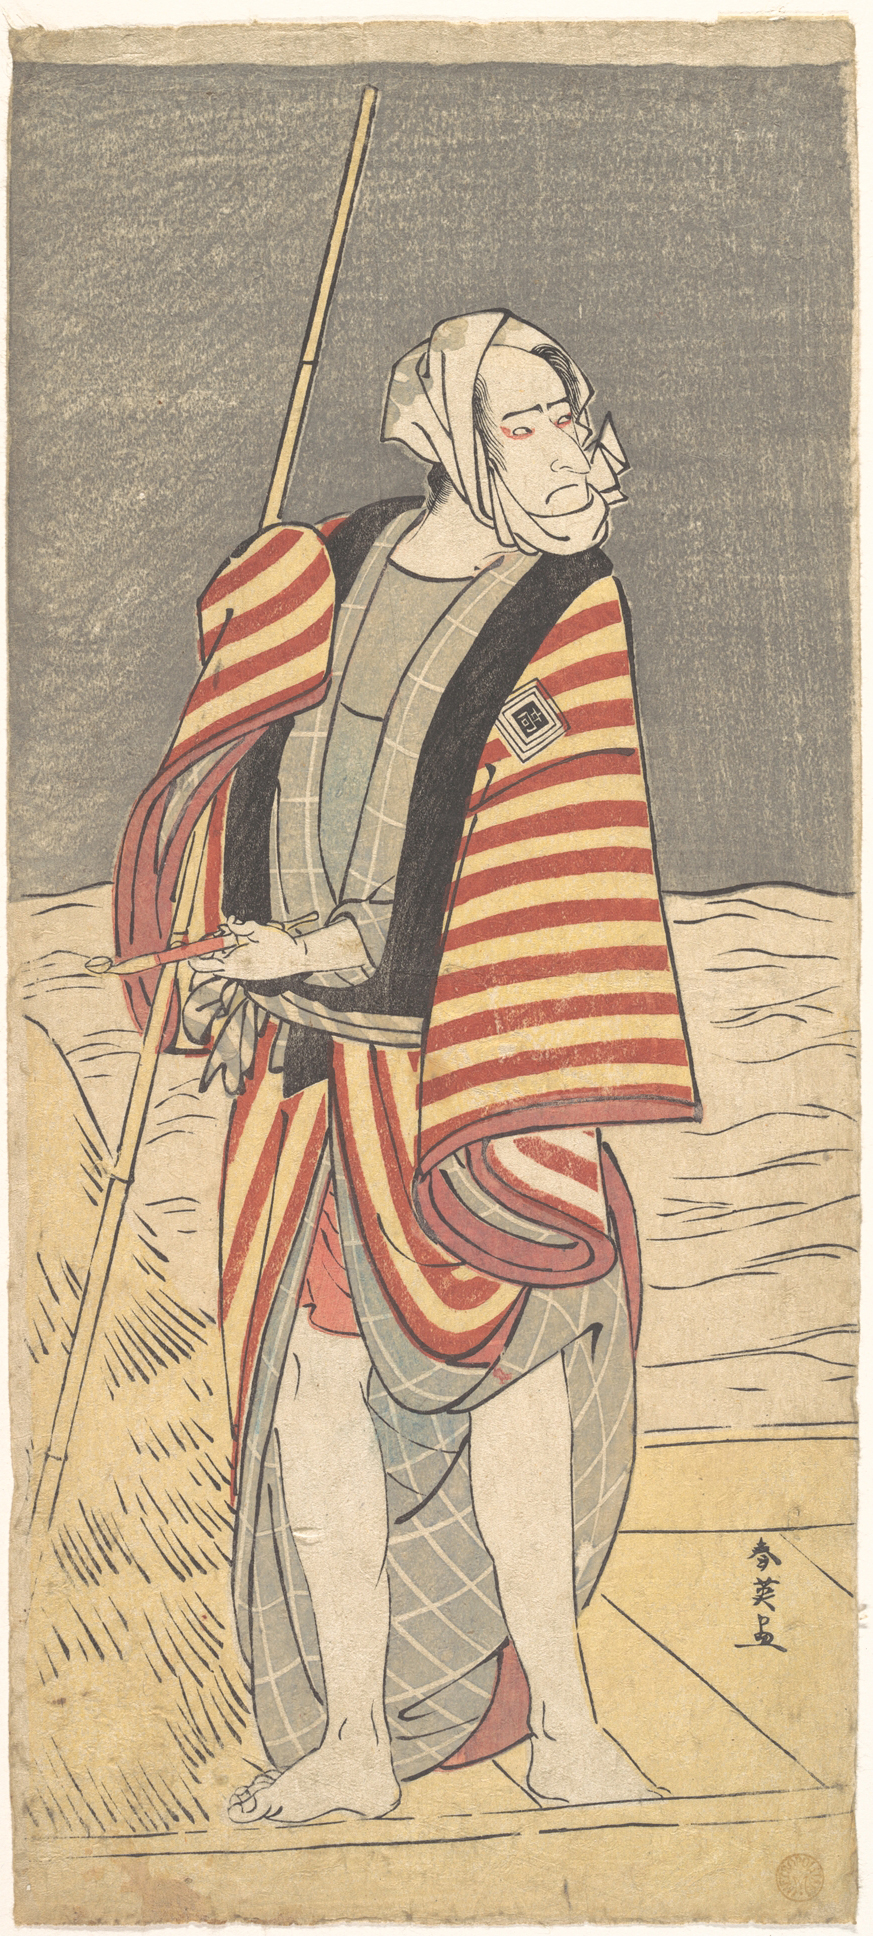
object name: woodblock print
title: The Second Ichikawa Komazo as a Boatman Standing on the Deck of a Barge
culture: japanese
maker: katsukawa shun'ei 勝川春英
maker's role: artist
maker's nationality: japanese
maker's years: 1762-1819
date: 1793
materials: ink, paper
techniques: woodblock print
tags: men,actors